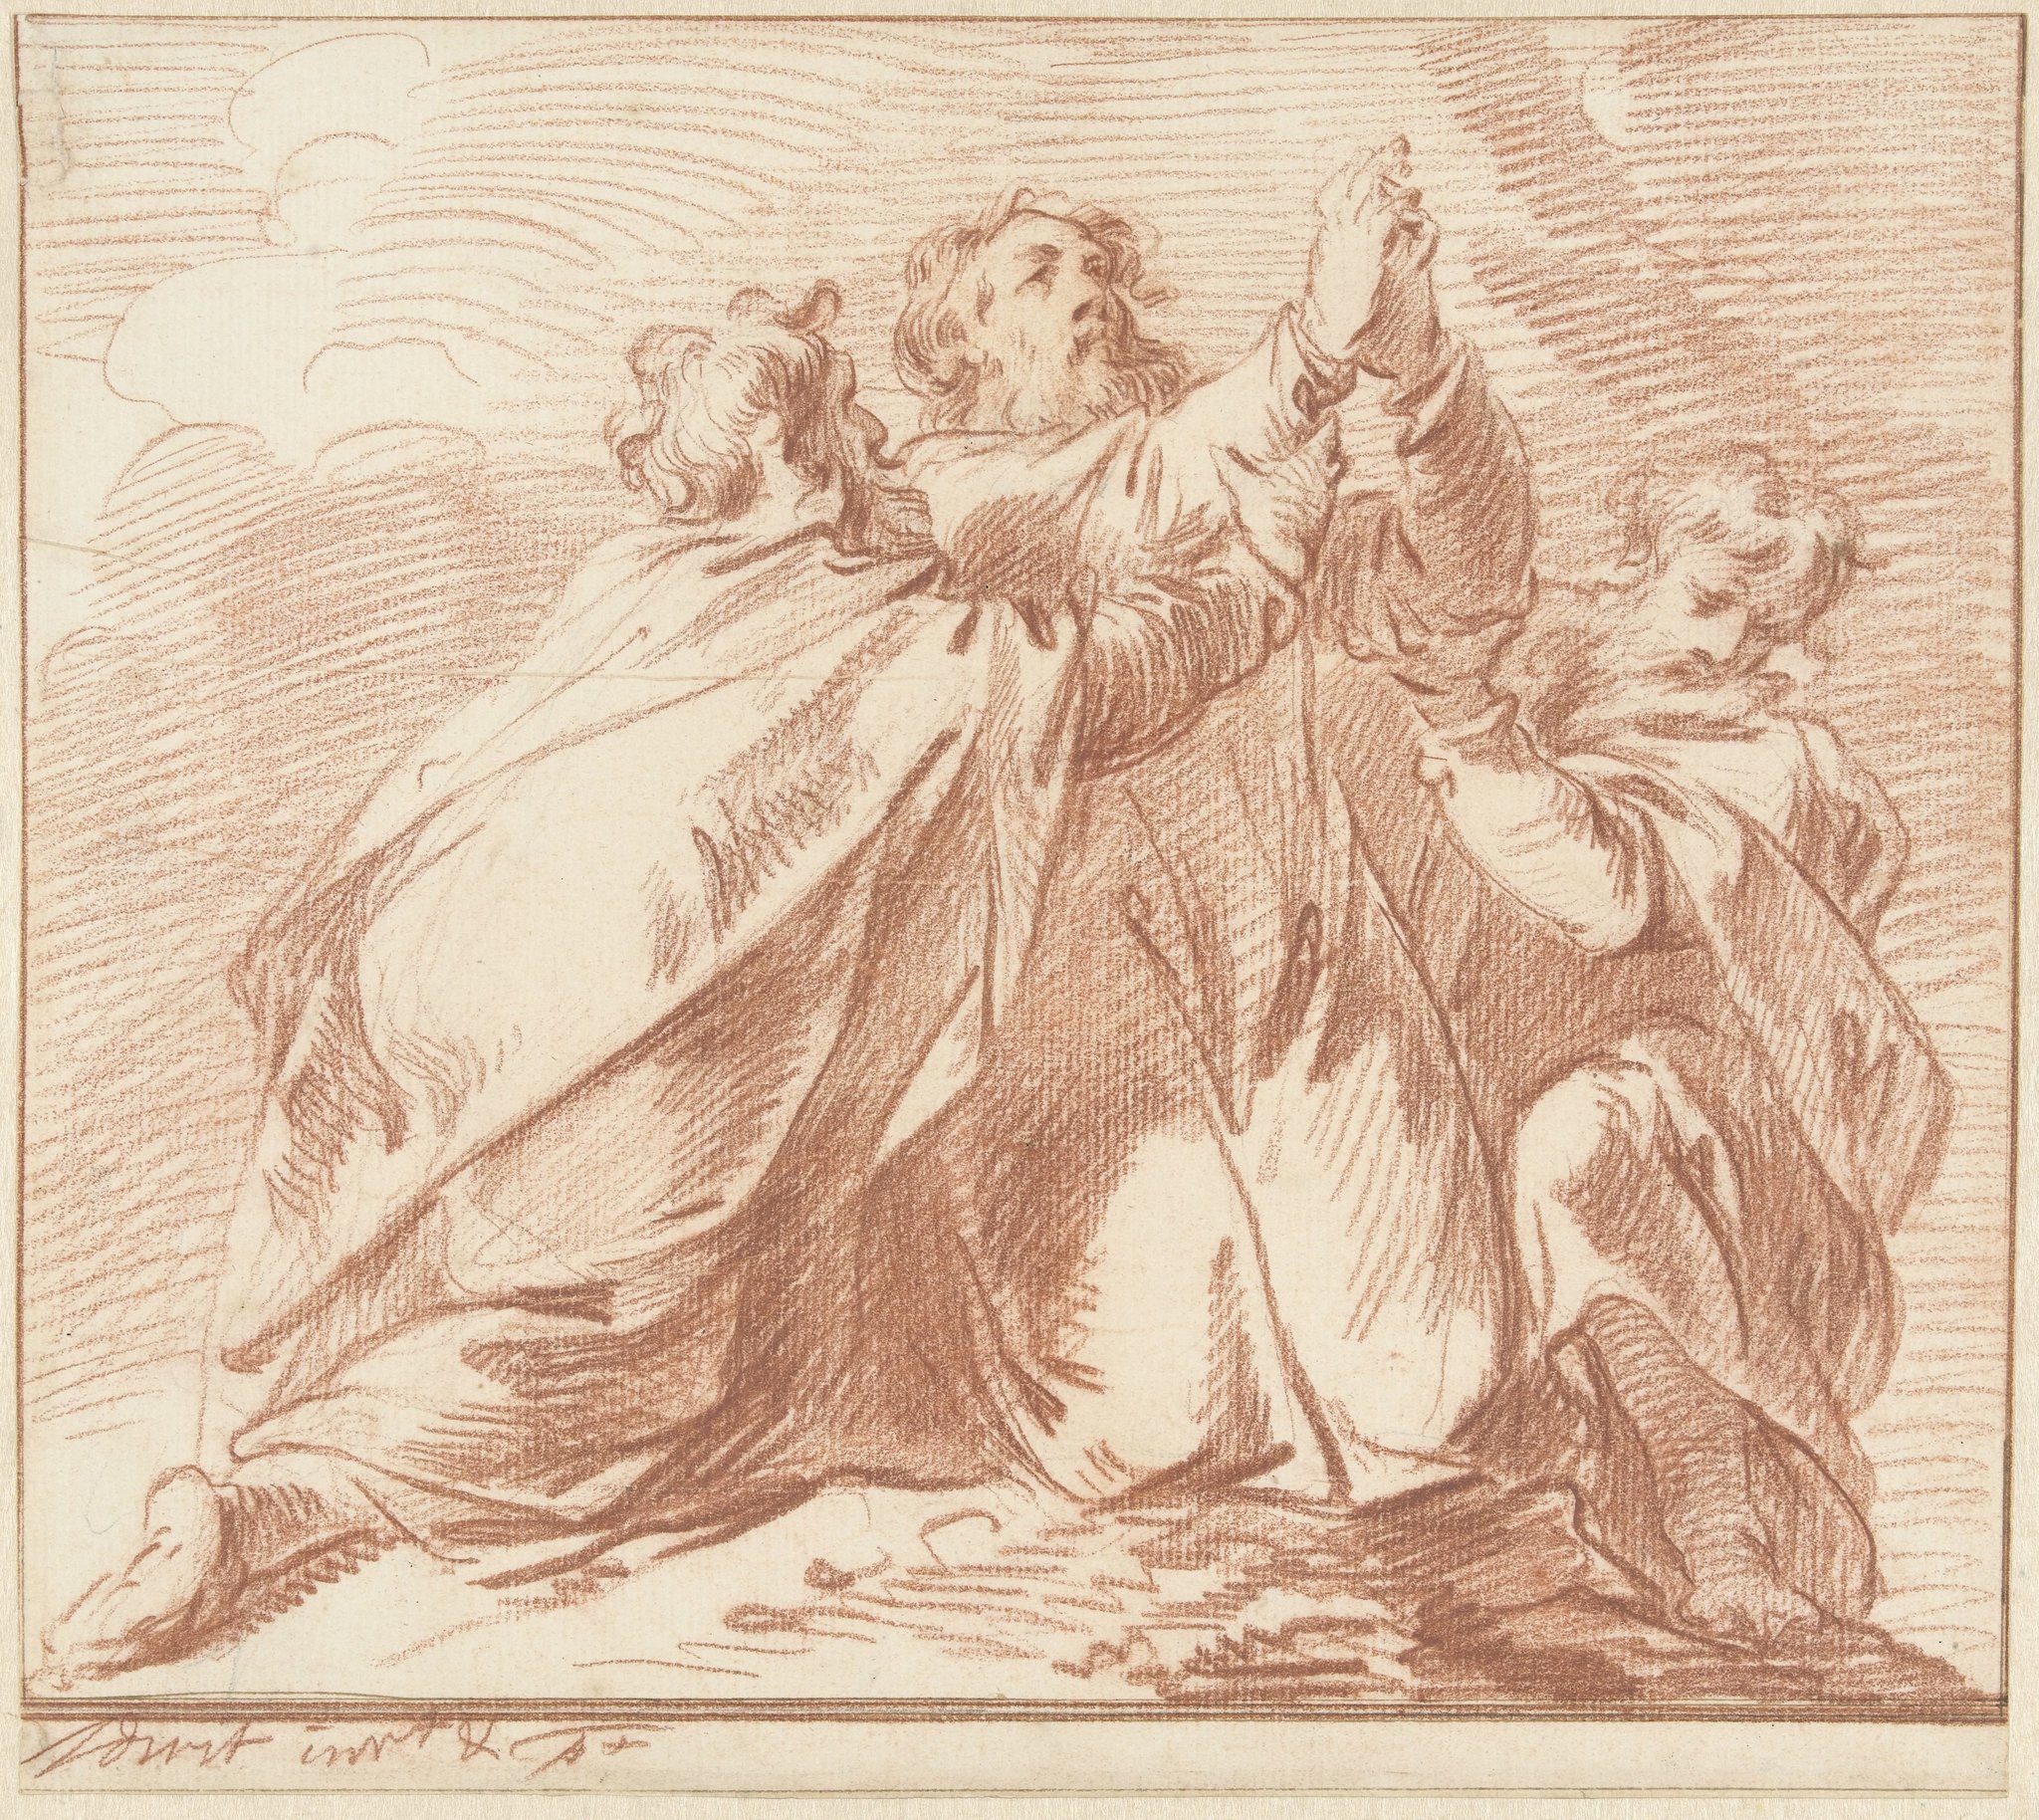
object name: design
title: Aäron en Hur stutten Mozes' handen tijdens de strijd van het volk Israël tegen de Amalekieten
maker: jacob de wit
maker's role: draughtsman, painter, print maker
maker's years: 1695-1754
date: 1705-1754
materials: chalk, paper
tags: moses goes to the top of a hill with aaron and hur and raises his arms to make the israelites victorious, crown (symbol of sovereignty), king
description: Aäron en Hur stutten Mozes' handen tijdens de strijd van het volk Israël tegen de Amalekieten (Exodus 13:7). Ontwerp voor een schildering.